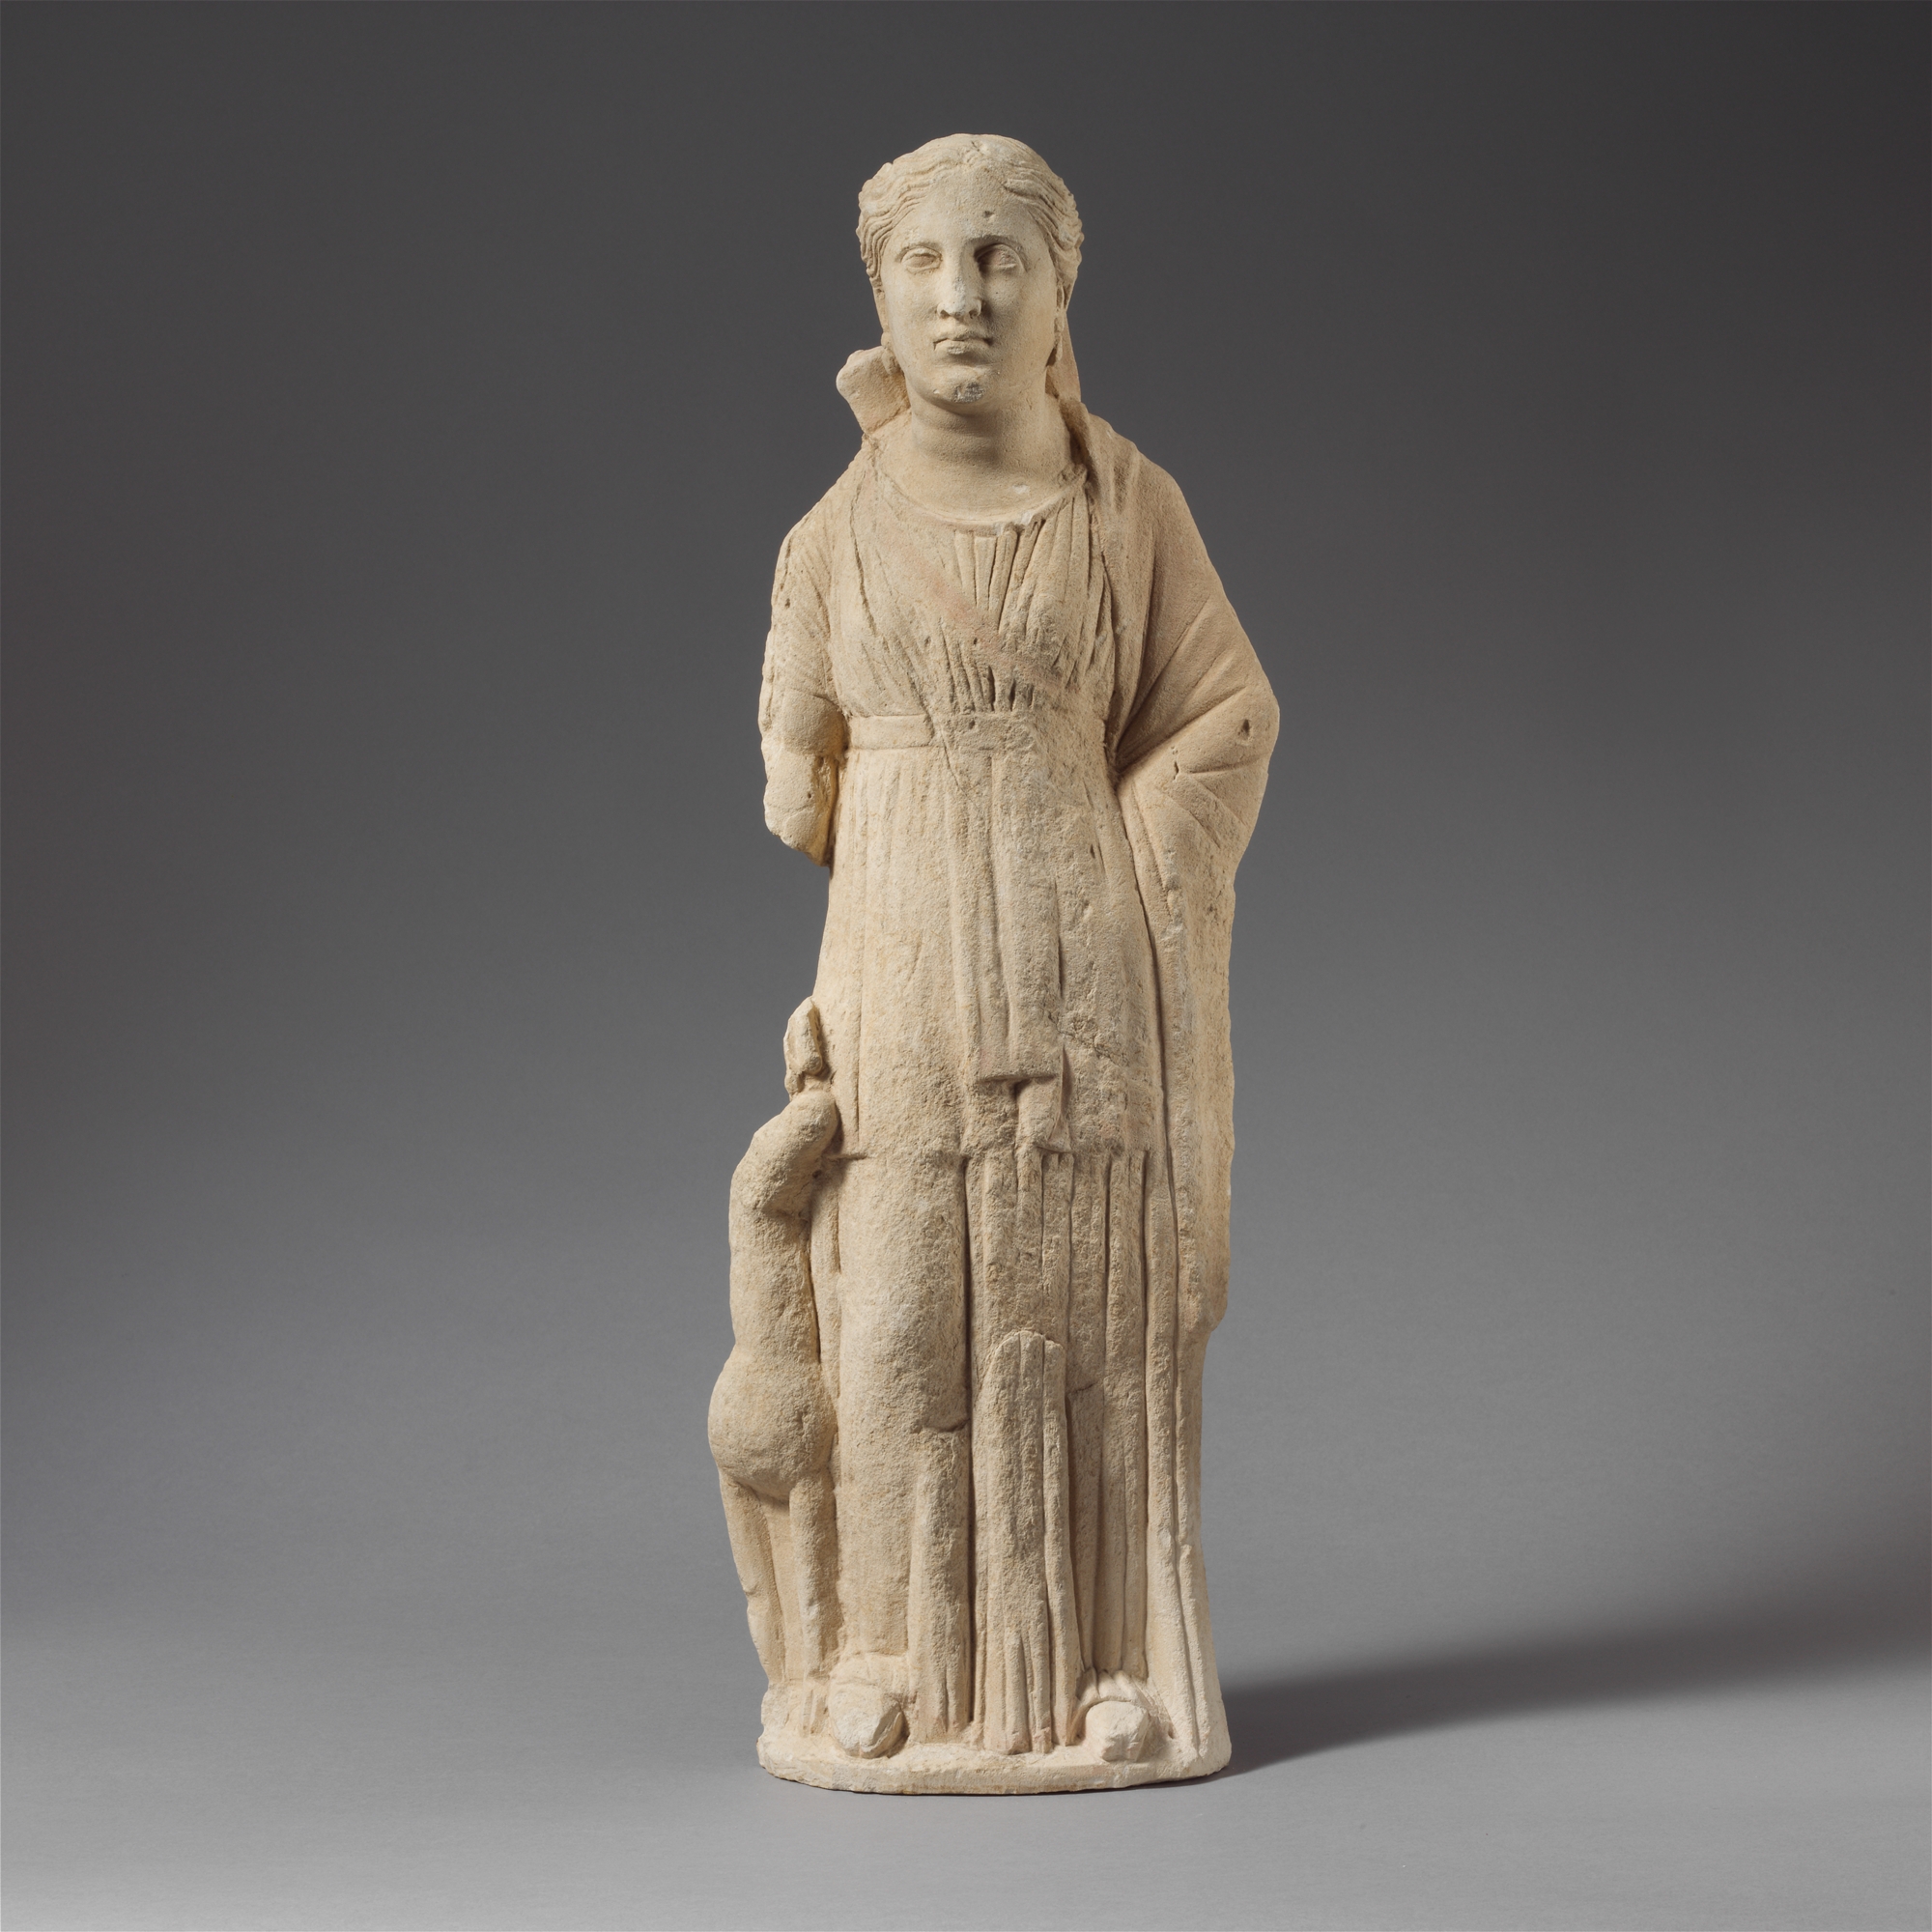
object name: statuette of artemis with fawn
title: Limestone statuette of Artemis with a fawn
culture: cypriot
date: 334-101 BCE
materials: limestone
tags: artemis,deer